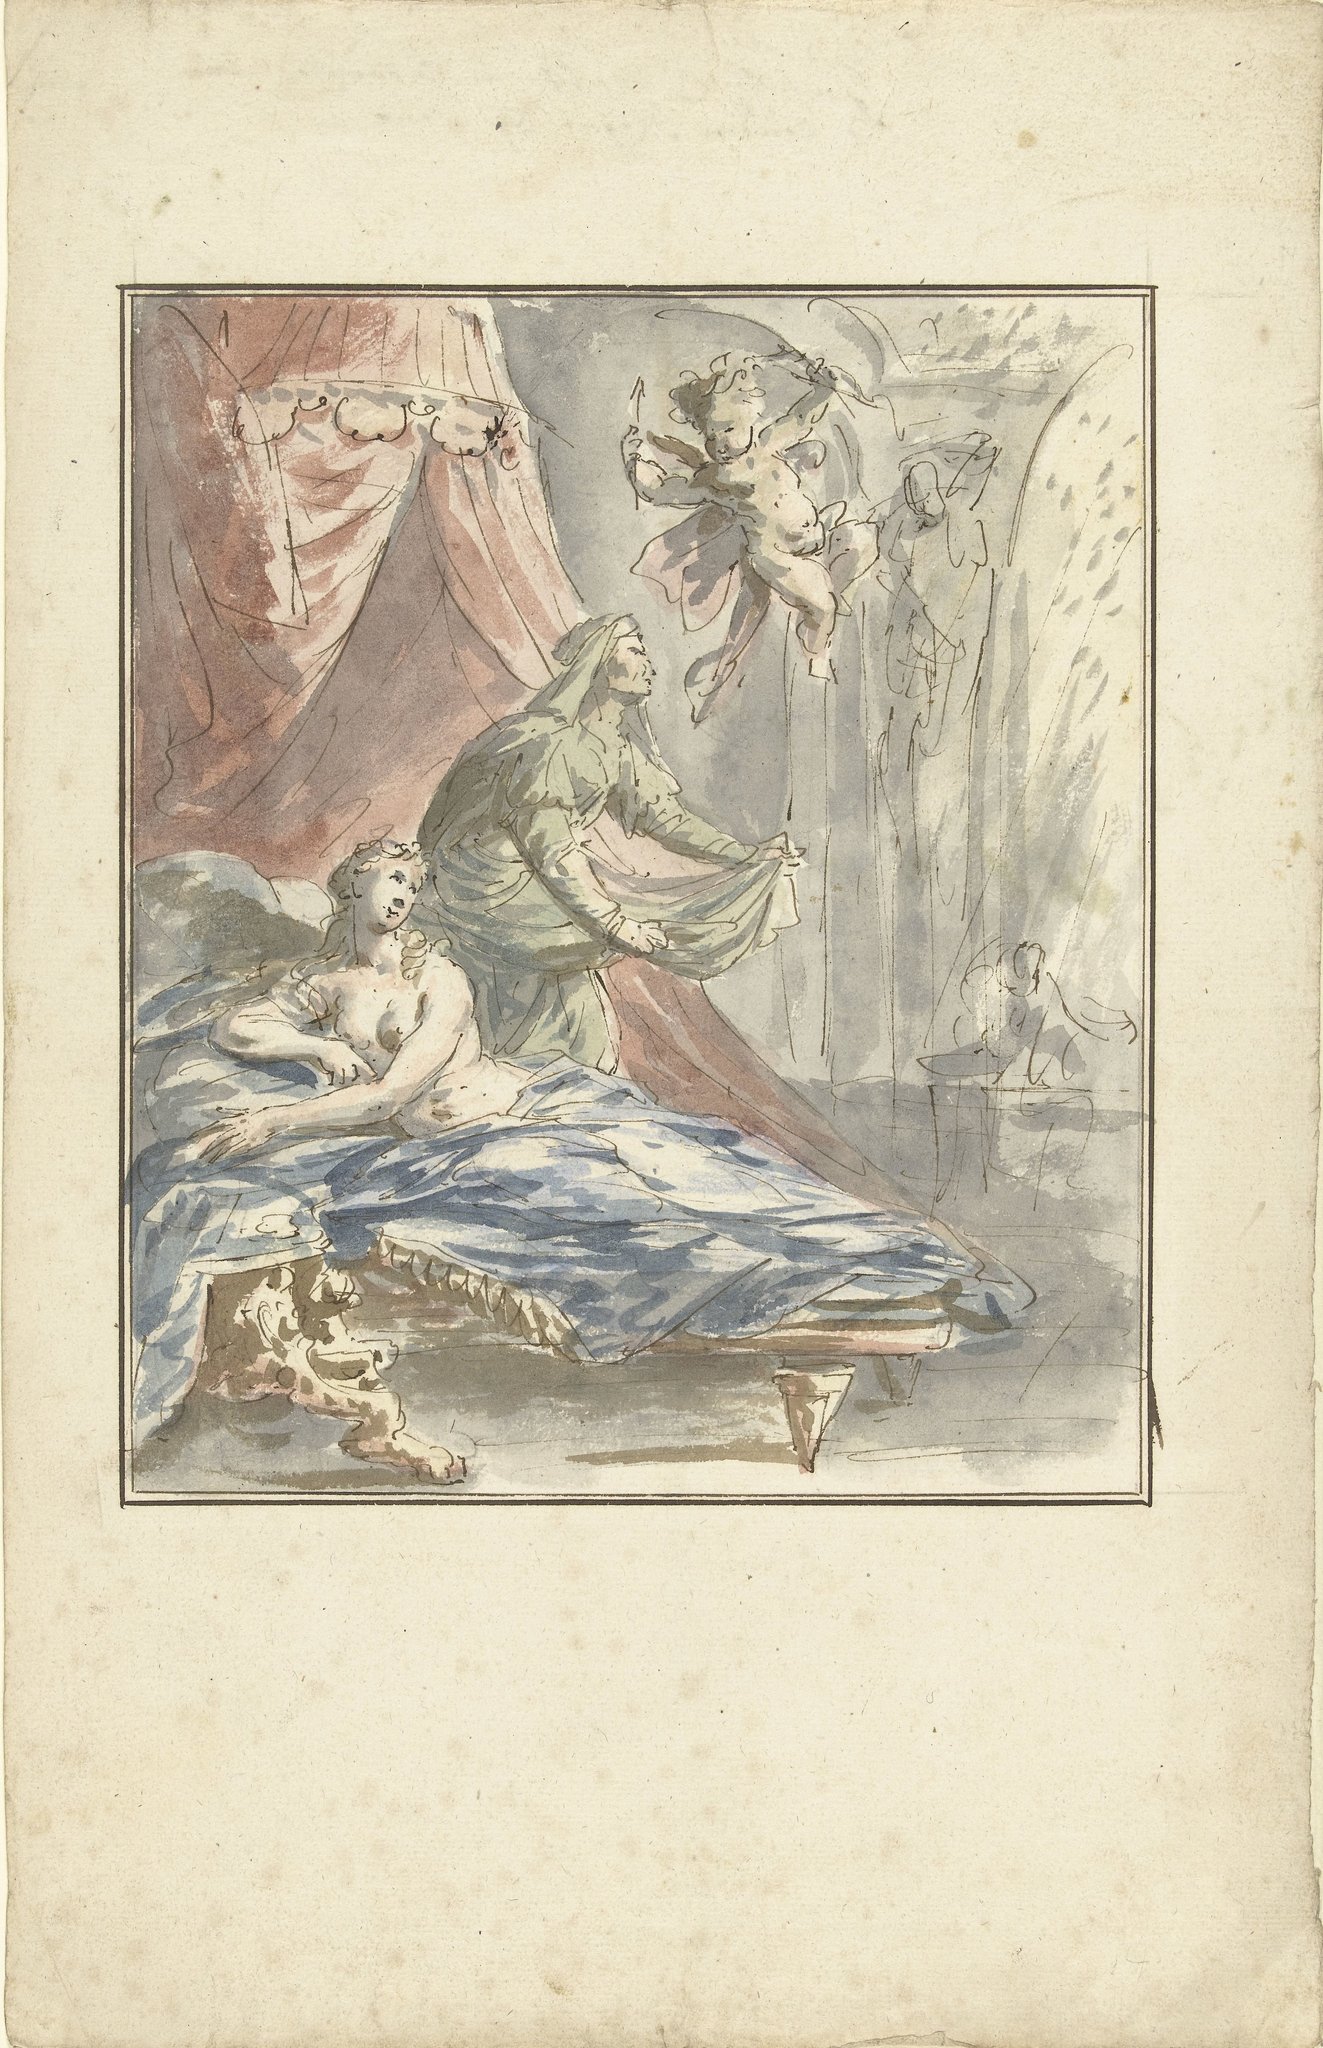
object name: drawing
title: Danaë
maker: elias van nijmegen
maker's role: draughtsman, painter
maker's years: 1667-1755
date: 1677-1755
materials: ink, paper, pencil, watercolor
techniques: brush, pen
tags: jupiter wooing danae; she is usually lying in bed receiving a shower of gold